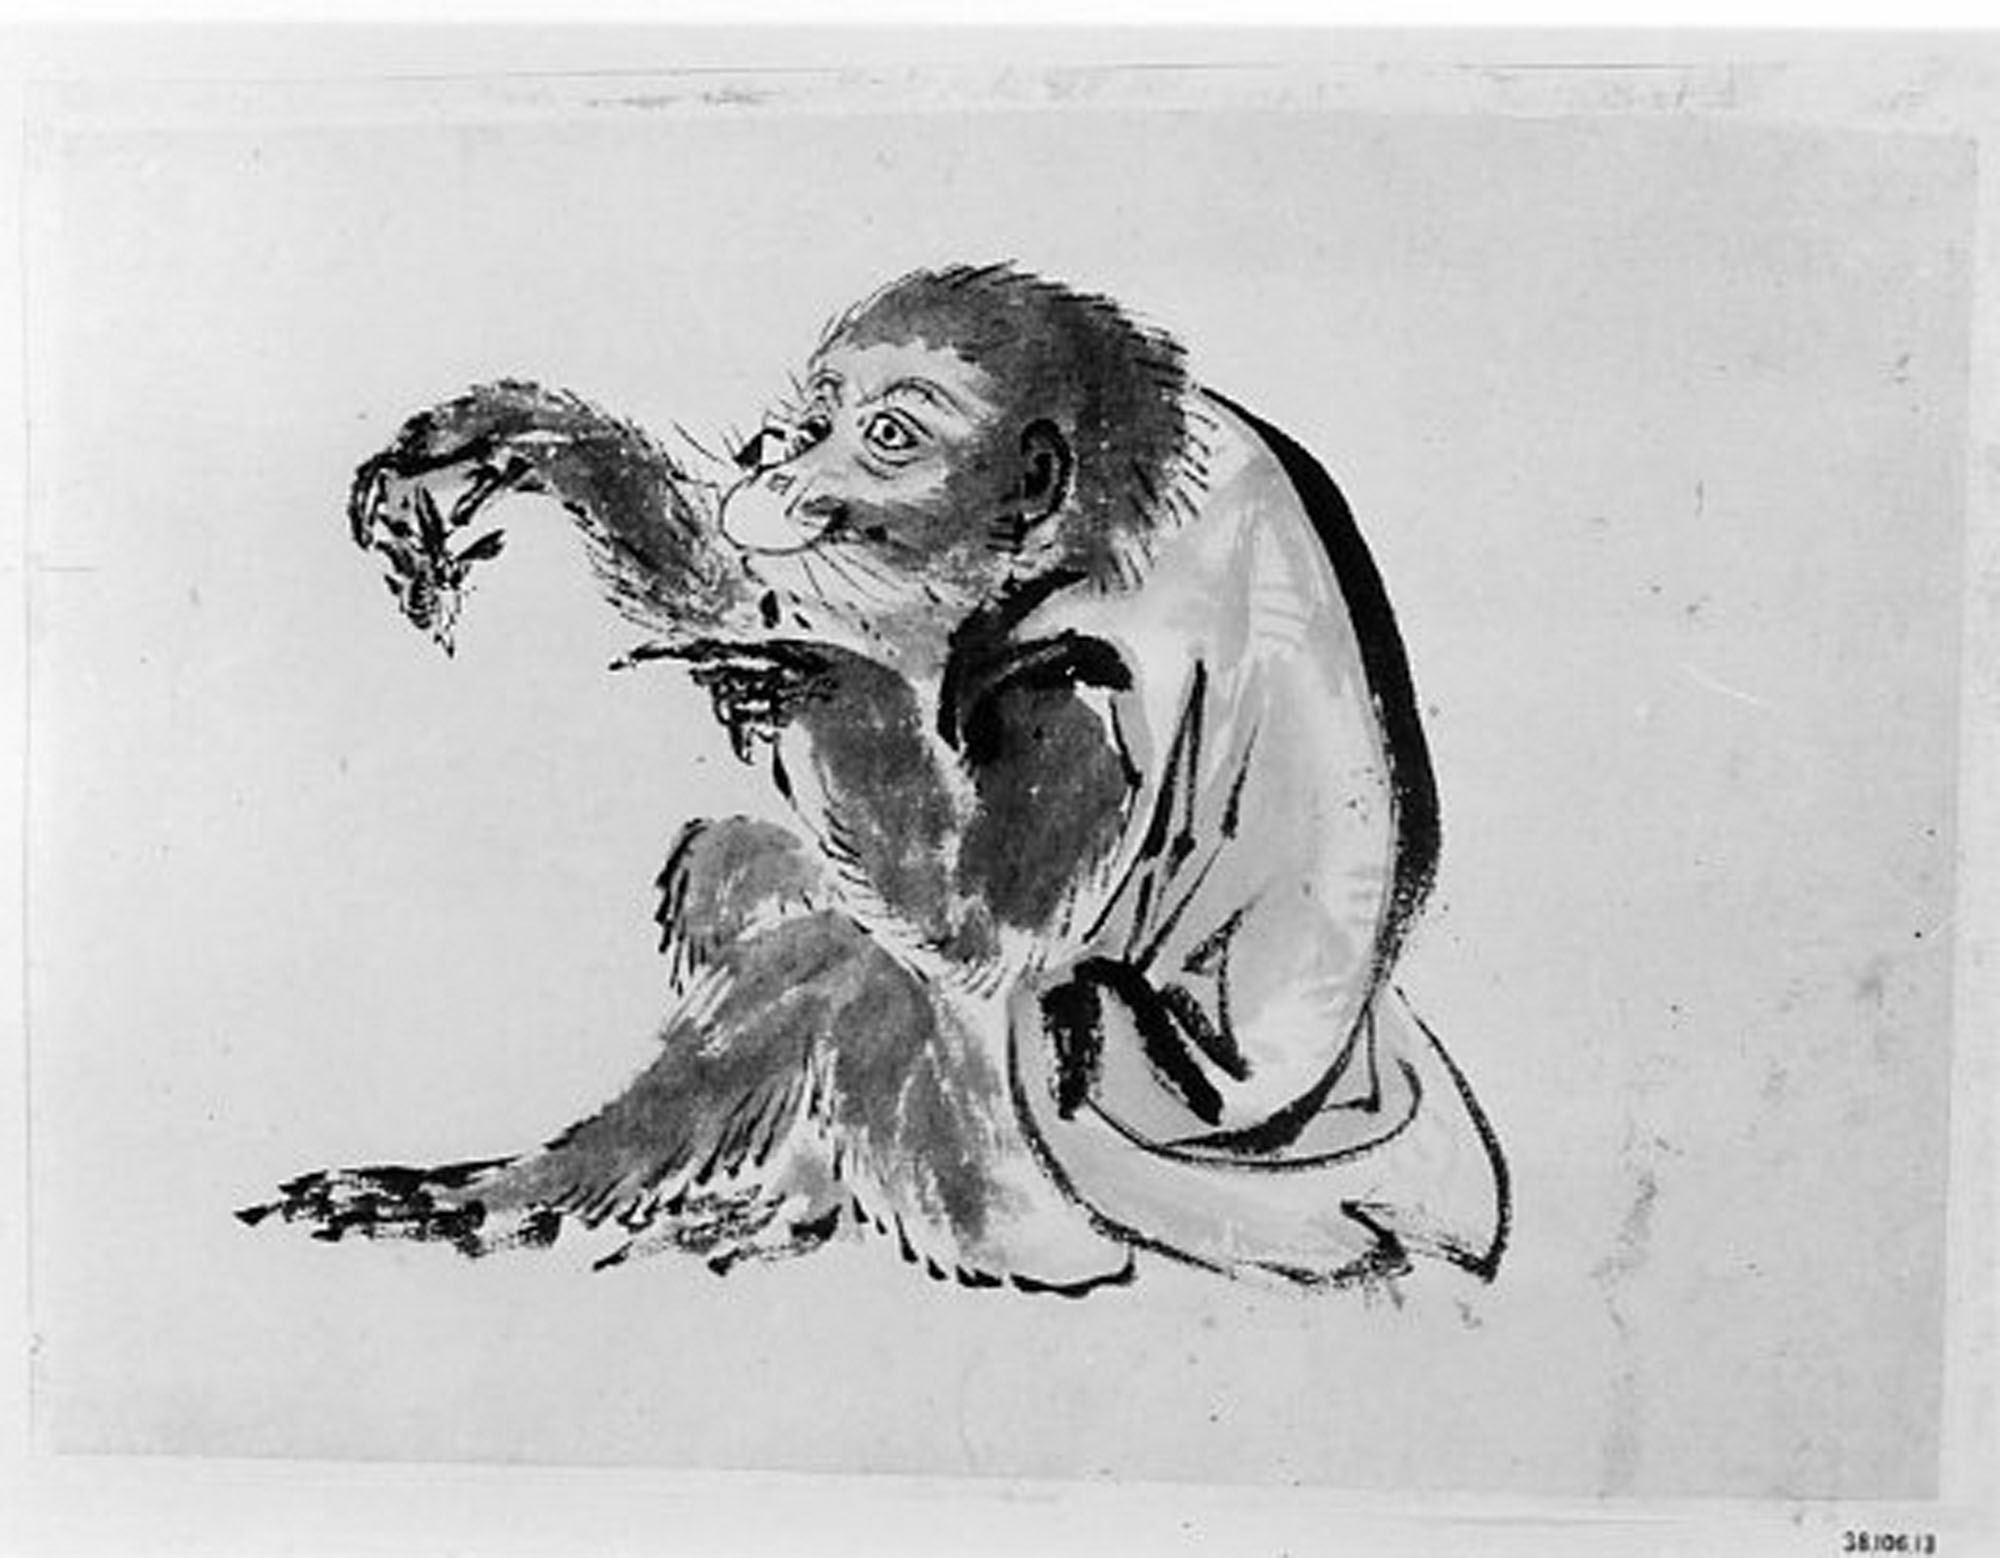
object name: painting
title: Monkey and Bee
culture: japanese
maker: hokusai school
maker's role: artist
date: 1801-1900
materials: ink, paper, watercolor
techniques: painting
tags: bees,monkeys